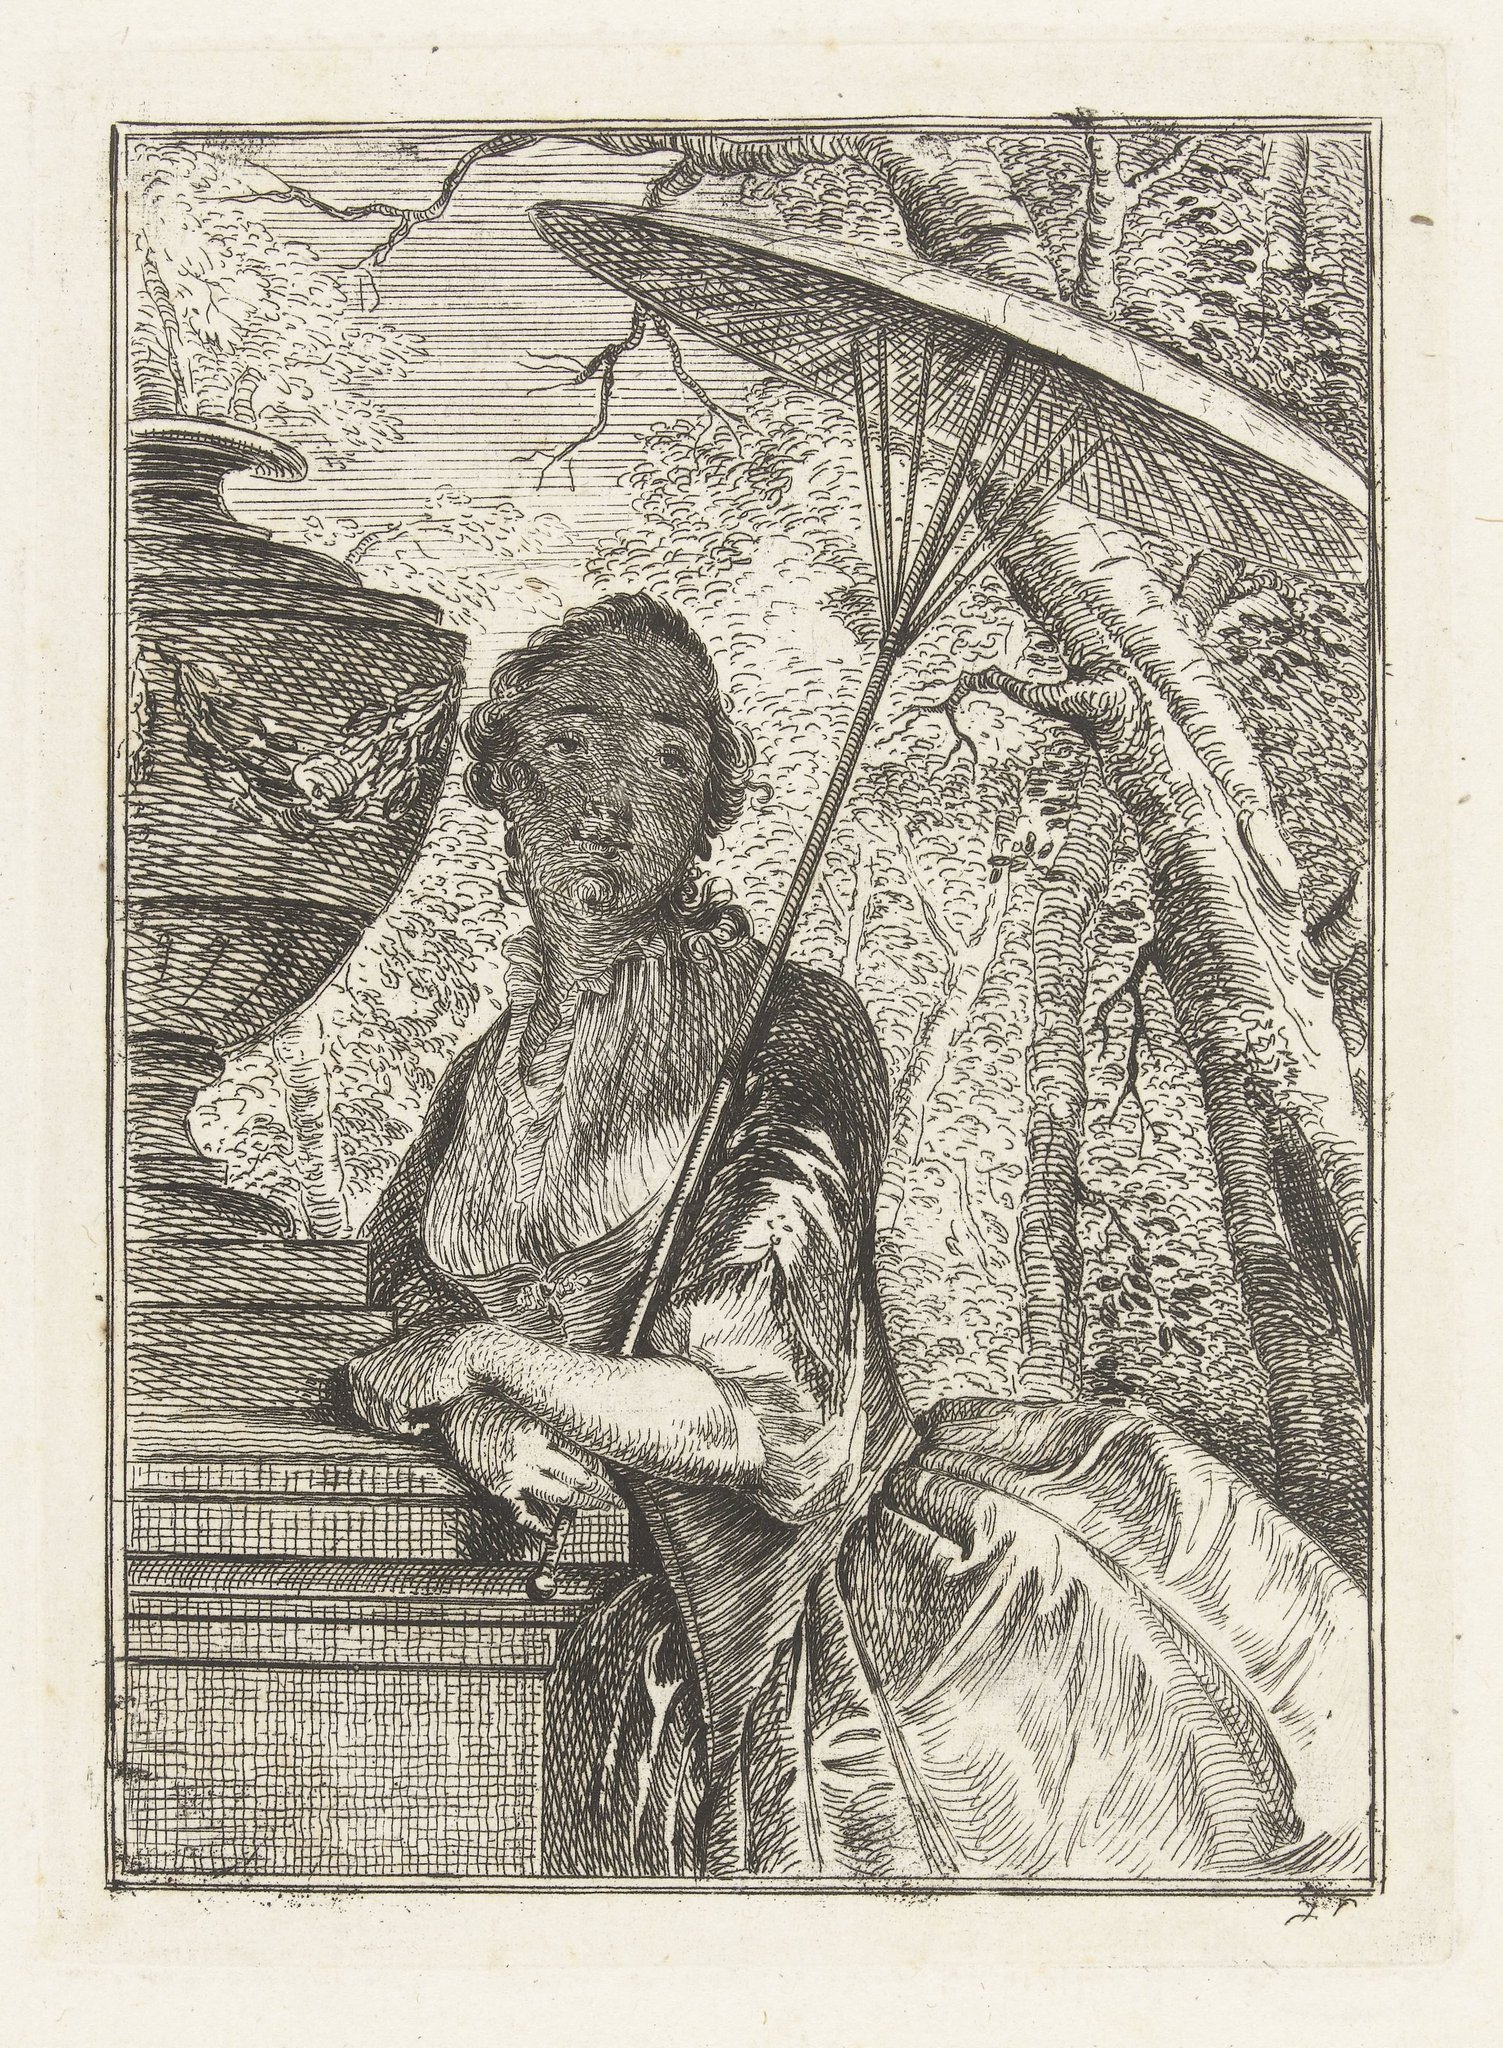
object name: print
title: Vrouw met parasol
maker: jacobus buys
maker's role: draughtsman, print maker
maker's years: 1724-1801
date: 1740-1801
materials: paper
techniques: etching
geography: amsterdam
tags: container of stone: stone vase, parasol, sunshade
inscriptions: collector's mark: Lugt 240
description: Een jonge vrouw beschermt met een parasol haar gezicht voor de zon in de tuin. Ze leunt tegen een sokkel met een stenen vaas aan.